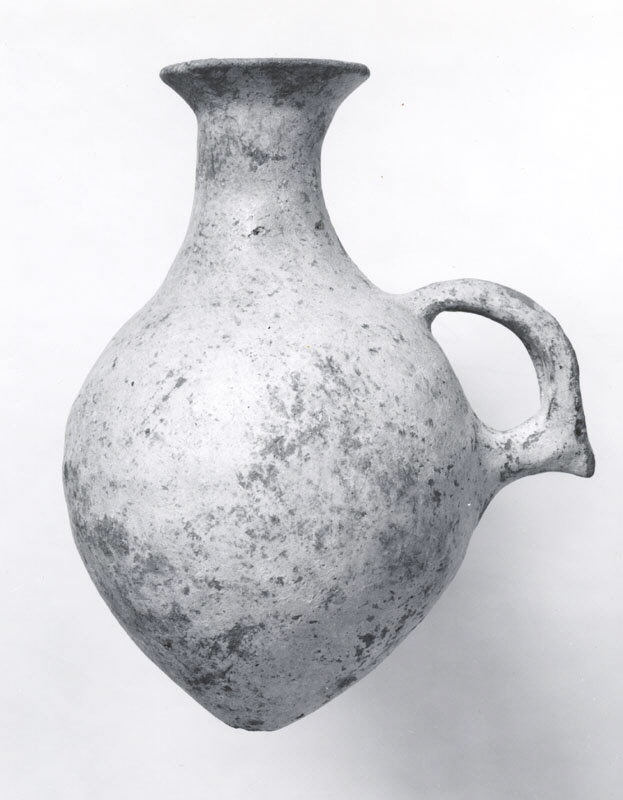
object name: rhyton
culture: iranian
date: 1000-1 BCE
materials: ceramic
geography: northwestern iran